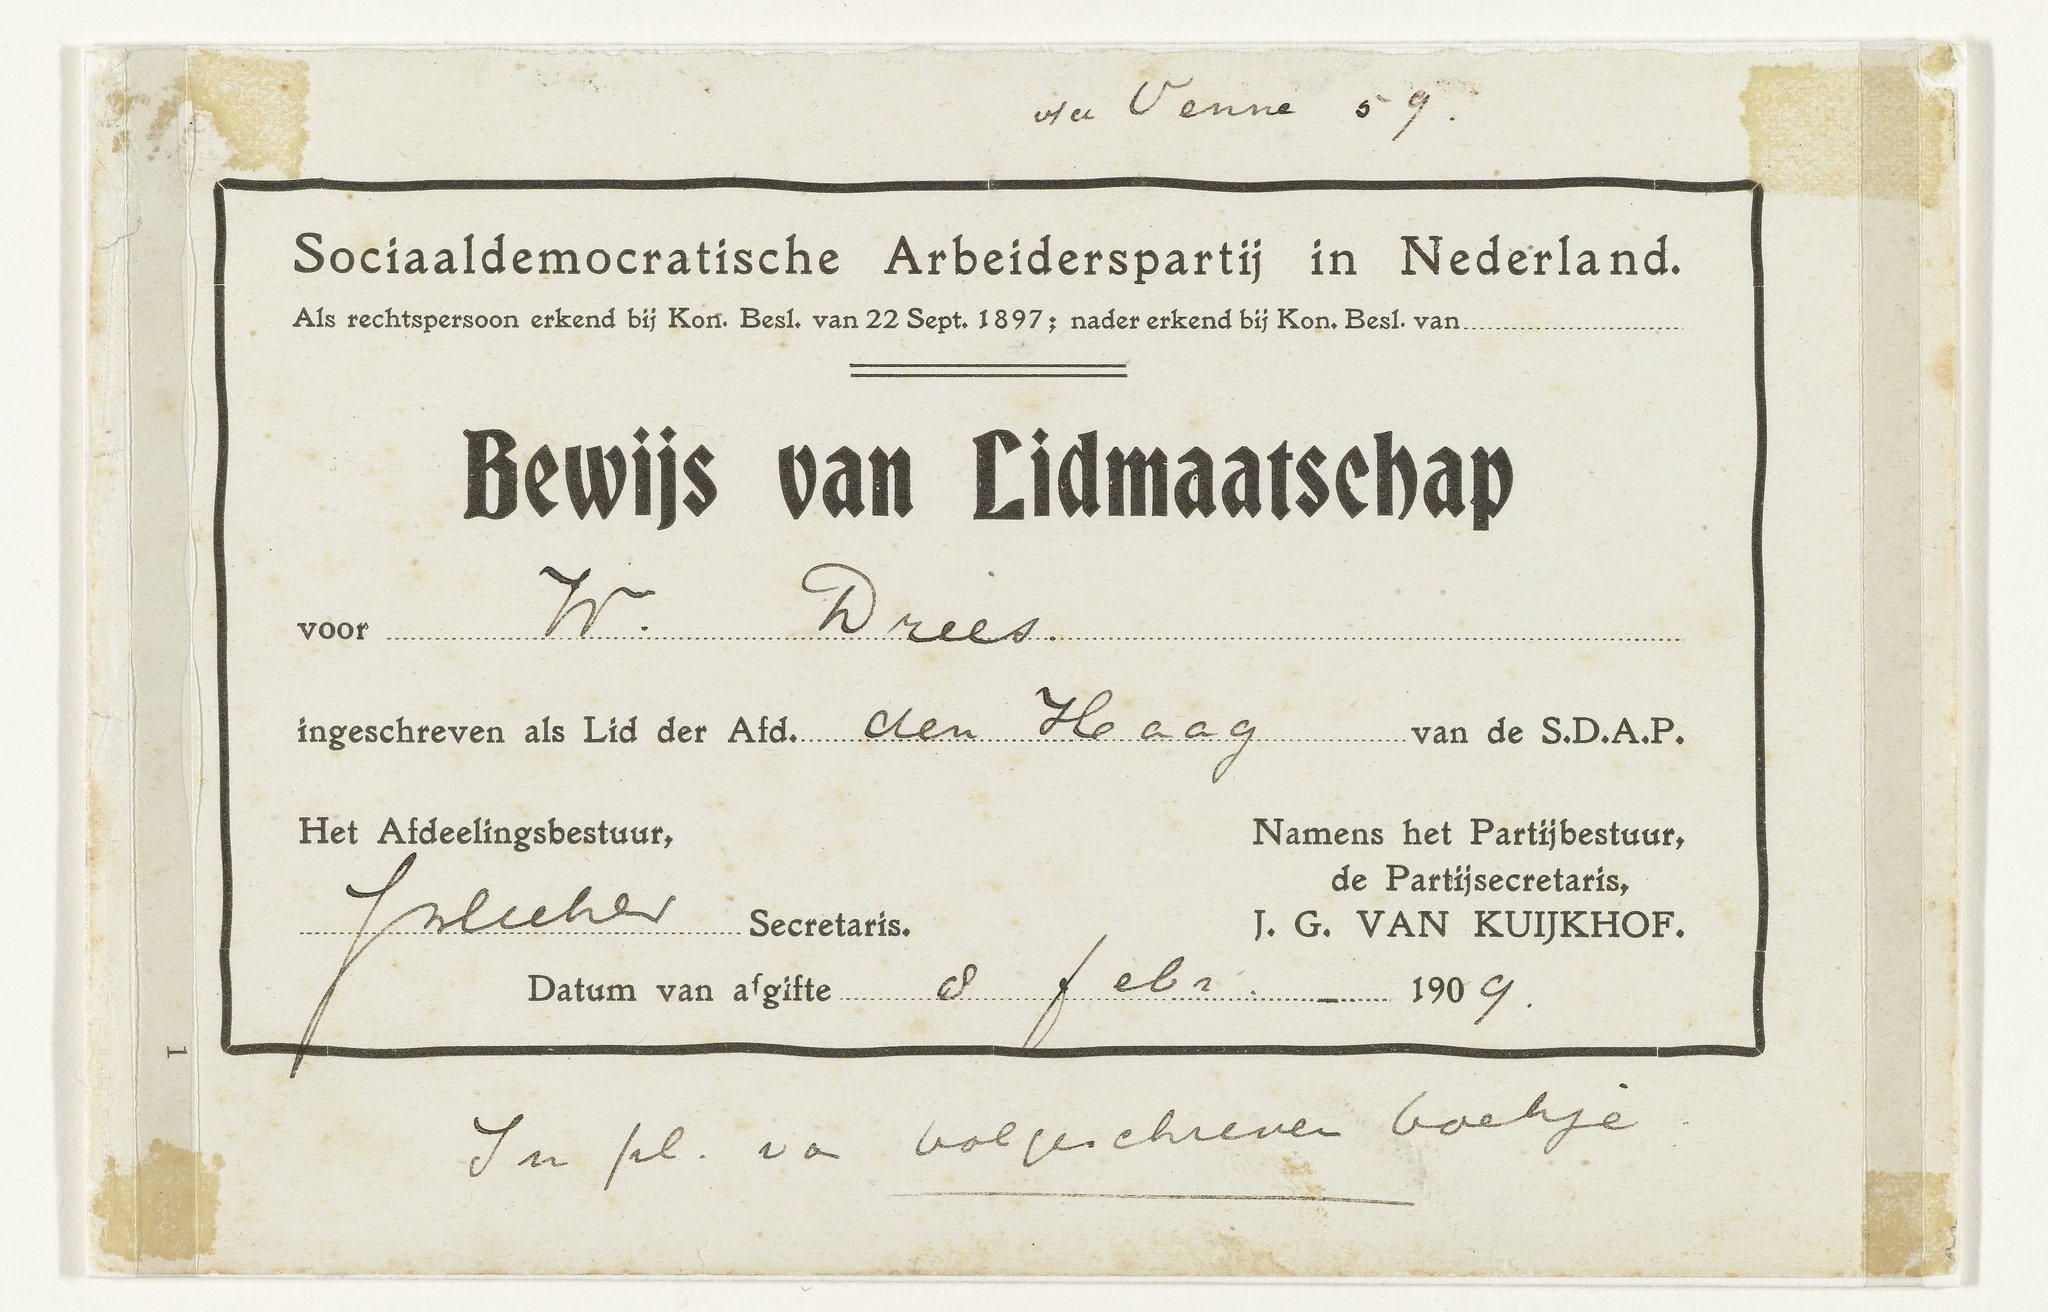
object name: membership certificate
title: Bewijs van lidmaatschap van de SDAP van Dr. W. Drees van 1909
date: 1909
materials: ink, paper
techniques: pen, printing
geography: netherlands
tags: amsterdam, willem drees, netherlands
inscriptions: date